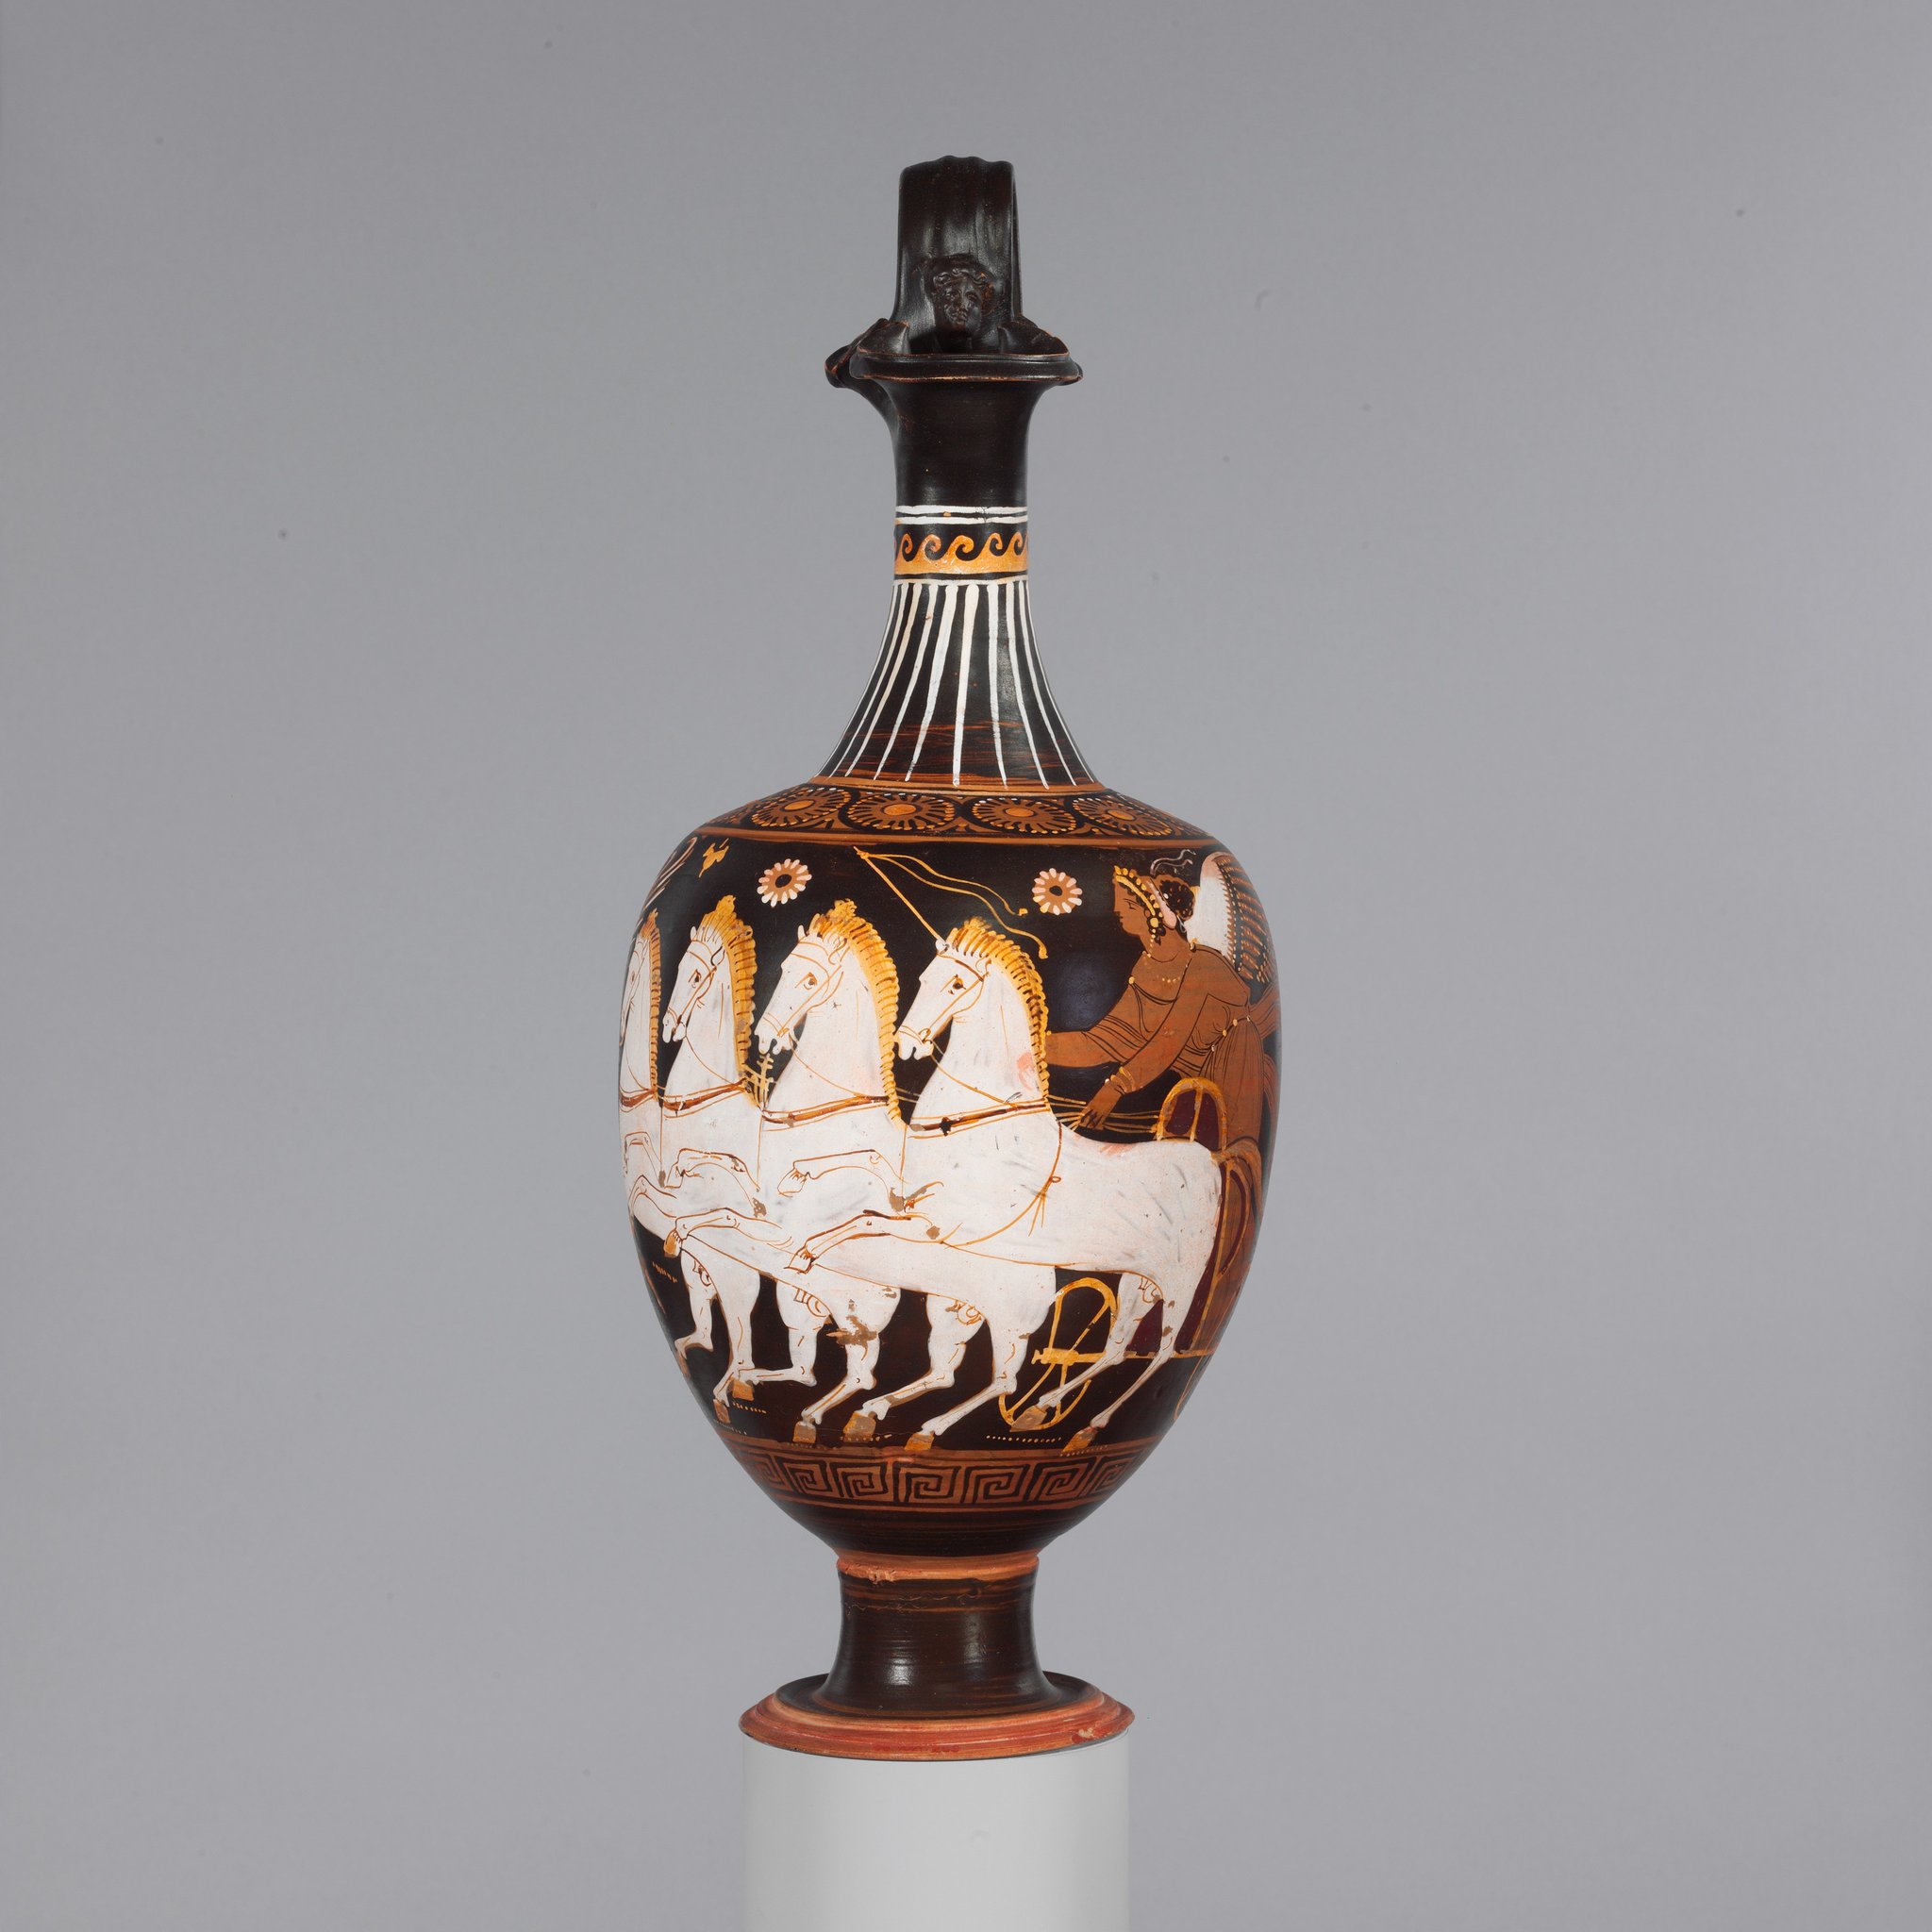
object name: oinochoe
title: Terracotta oinochoe (jug)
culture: greek, south italian, apulian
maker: stuttgart group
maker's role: artist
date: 325-300 BCE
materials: terracotta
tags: eros,nike,horses,chariots